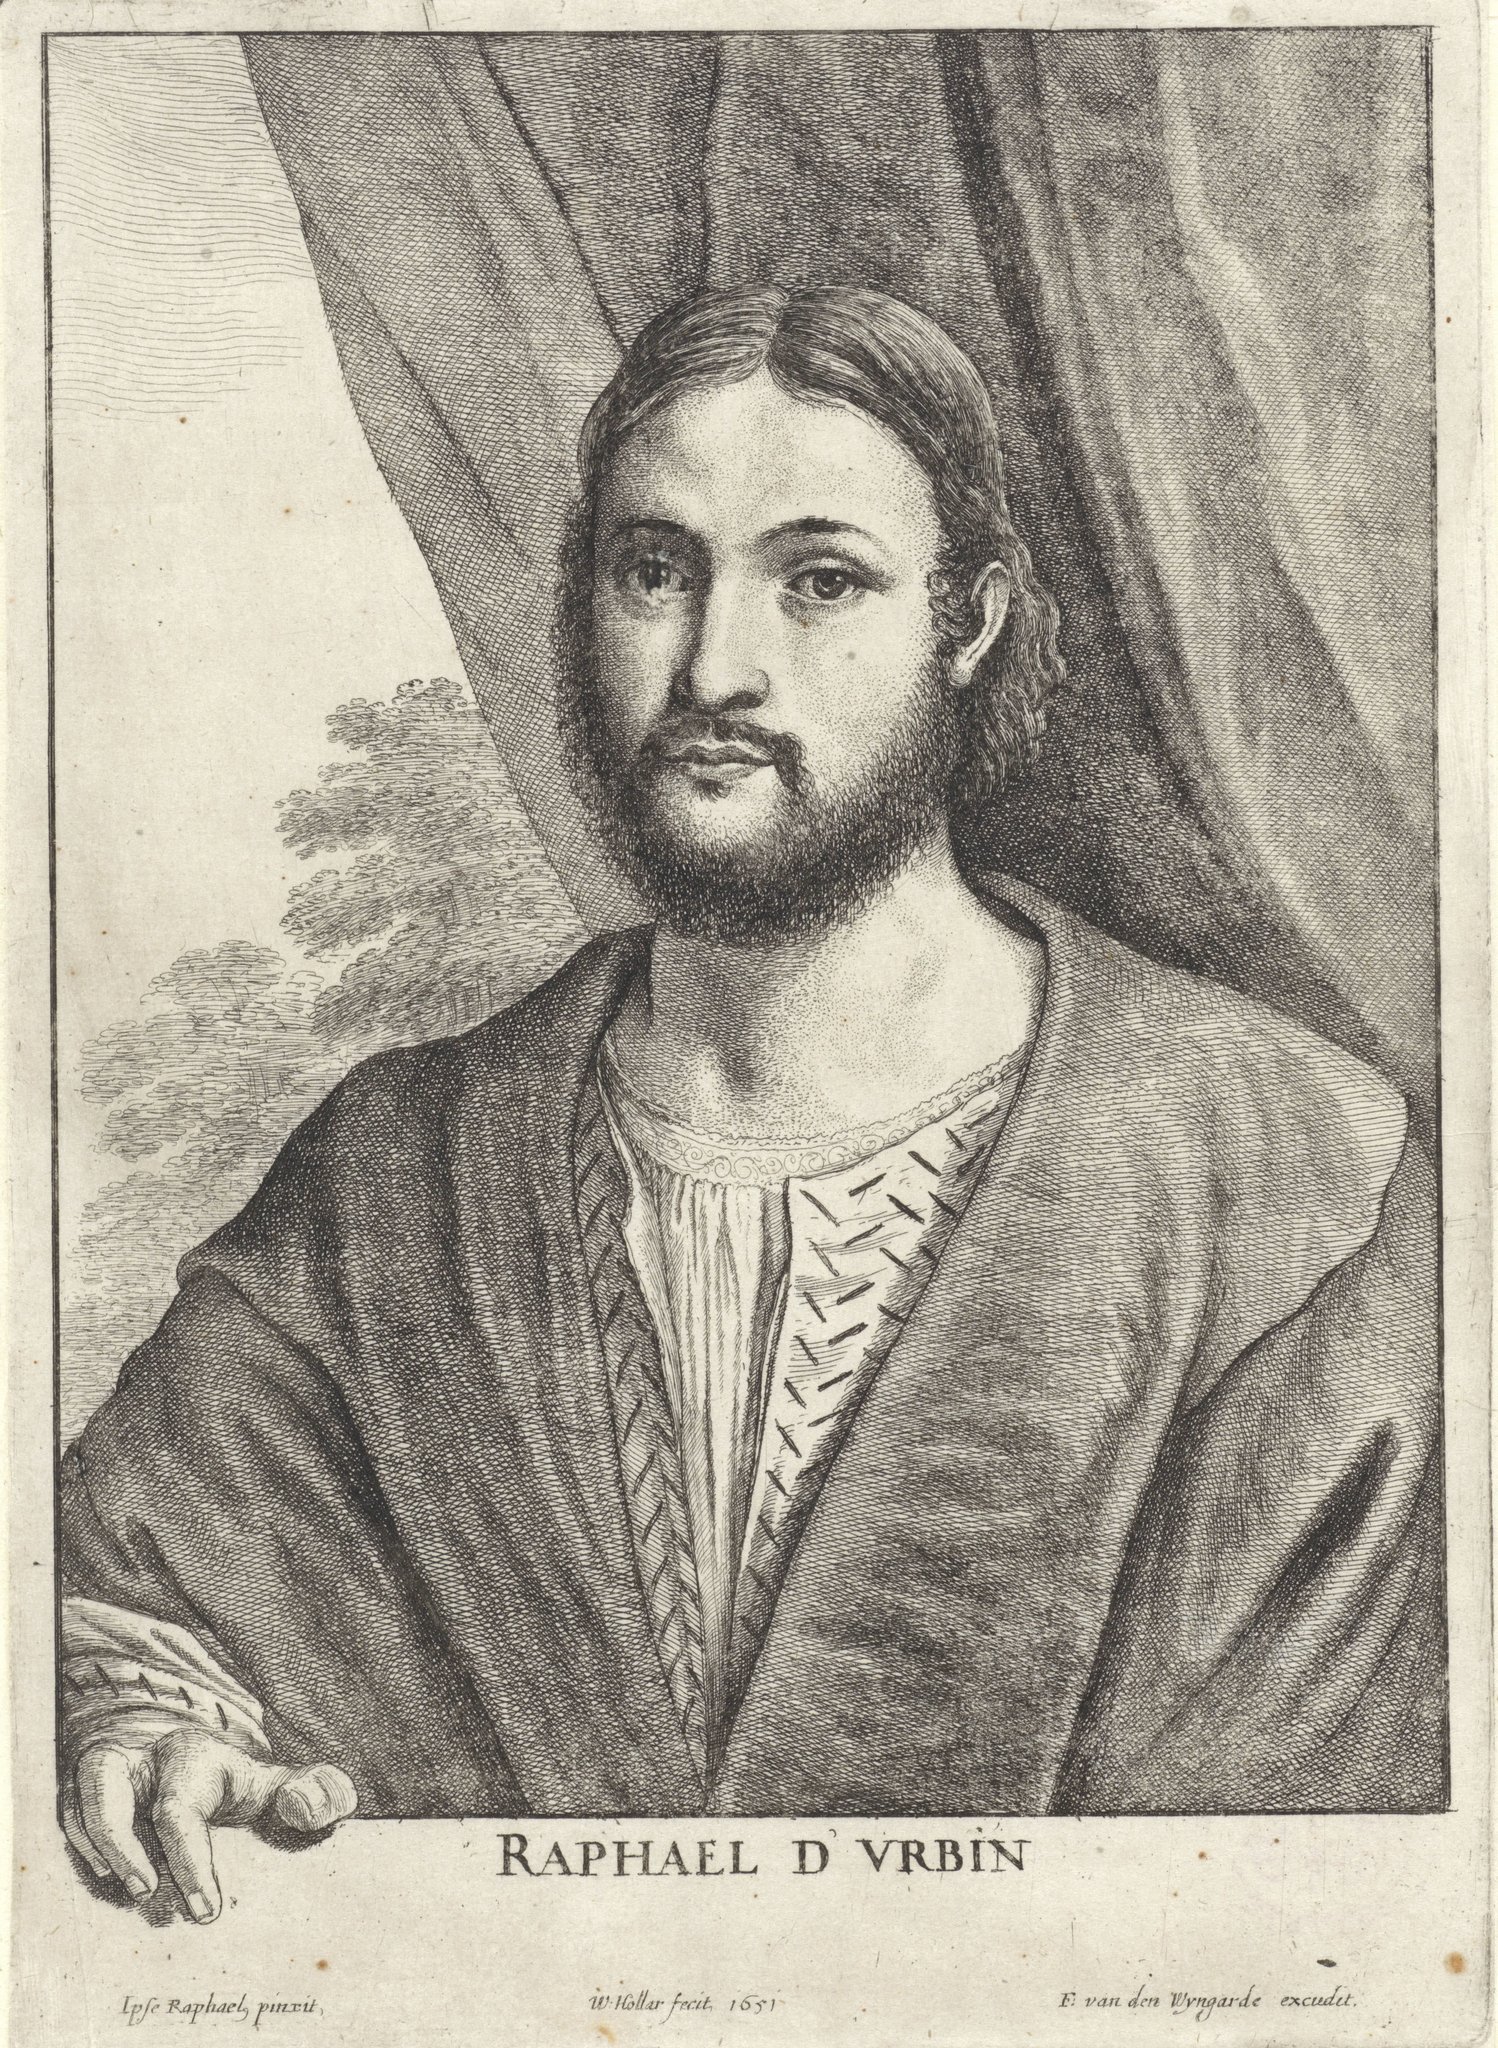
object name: print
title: Portret van Rafaël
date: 1649-1651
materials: paper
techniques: etching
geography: antwerp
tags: rome, painter, rafaël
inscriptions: collector's mark: Lugt 240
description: De prent maakt deel uit van een tiendelige serie met Italiaanse portretten (ongenummerd).